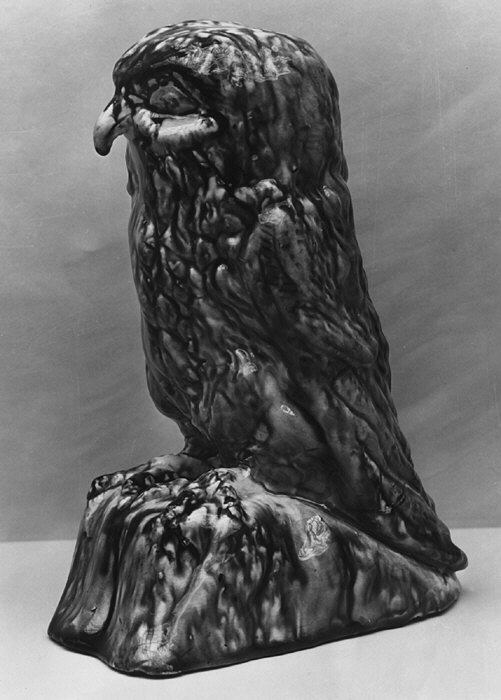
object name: figure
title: Owl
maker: whieldon type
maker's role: artist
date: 1750-1760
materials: earthenware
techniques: glazing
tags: owls